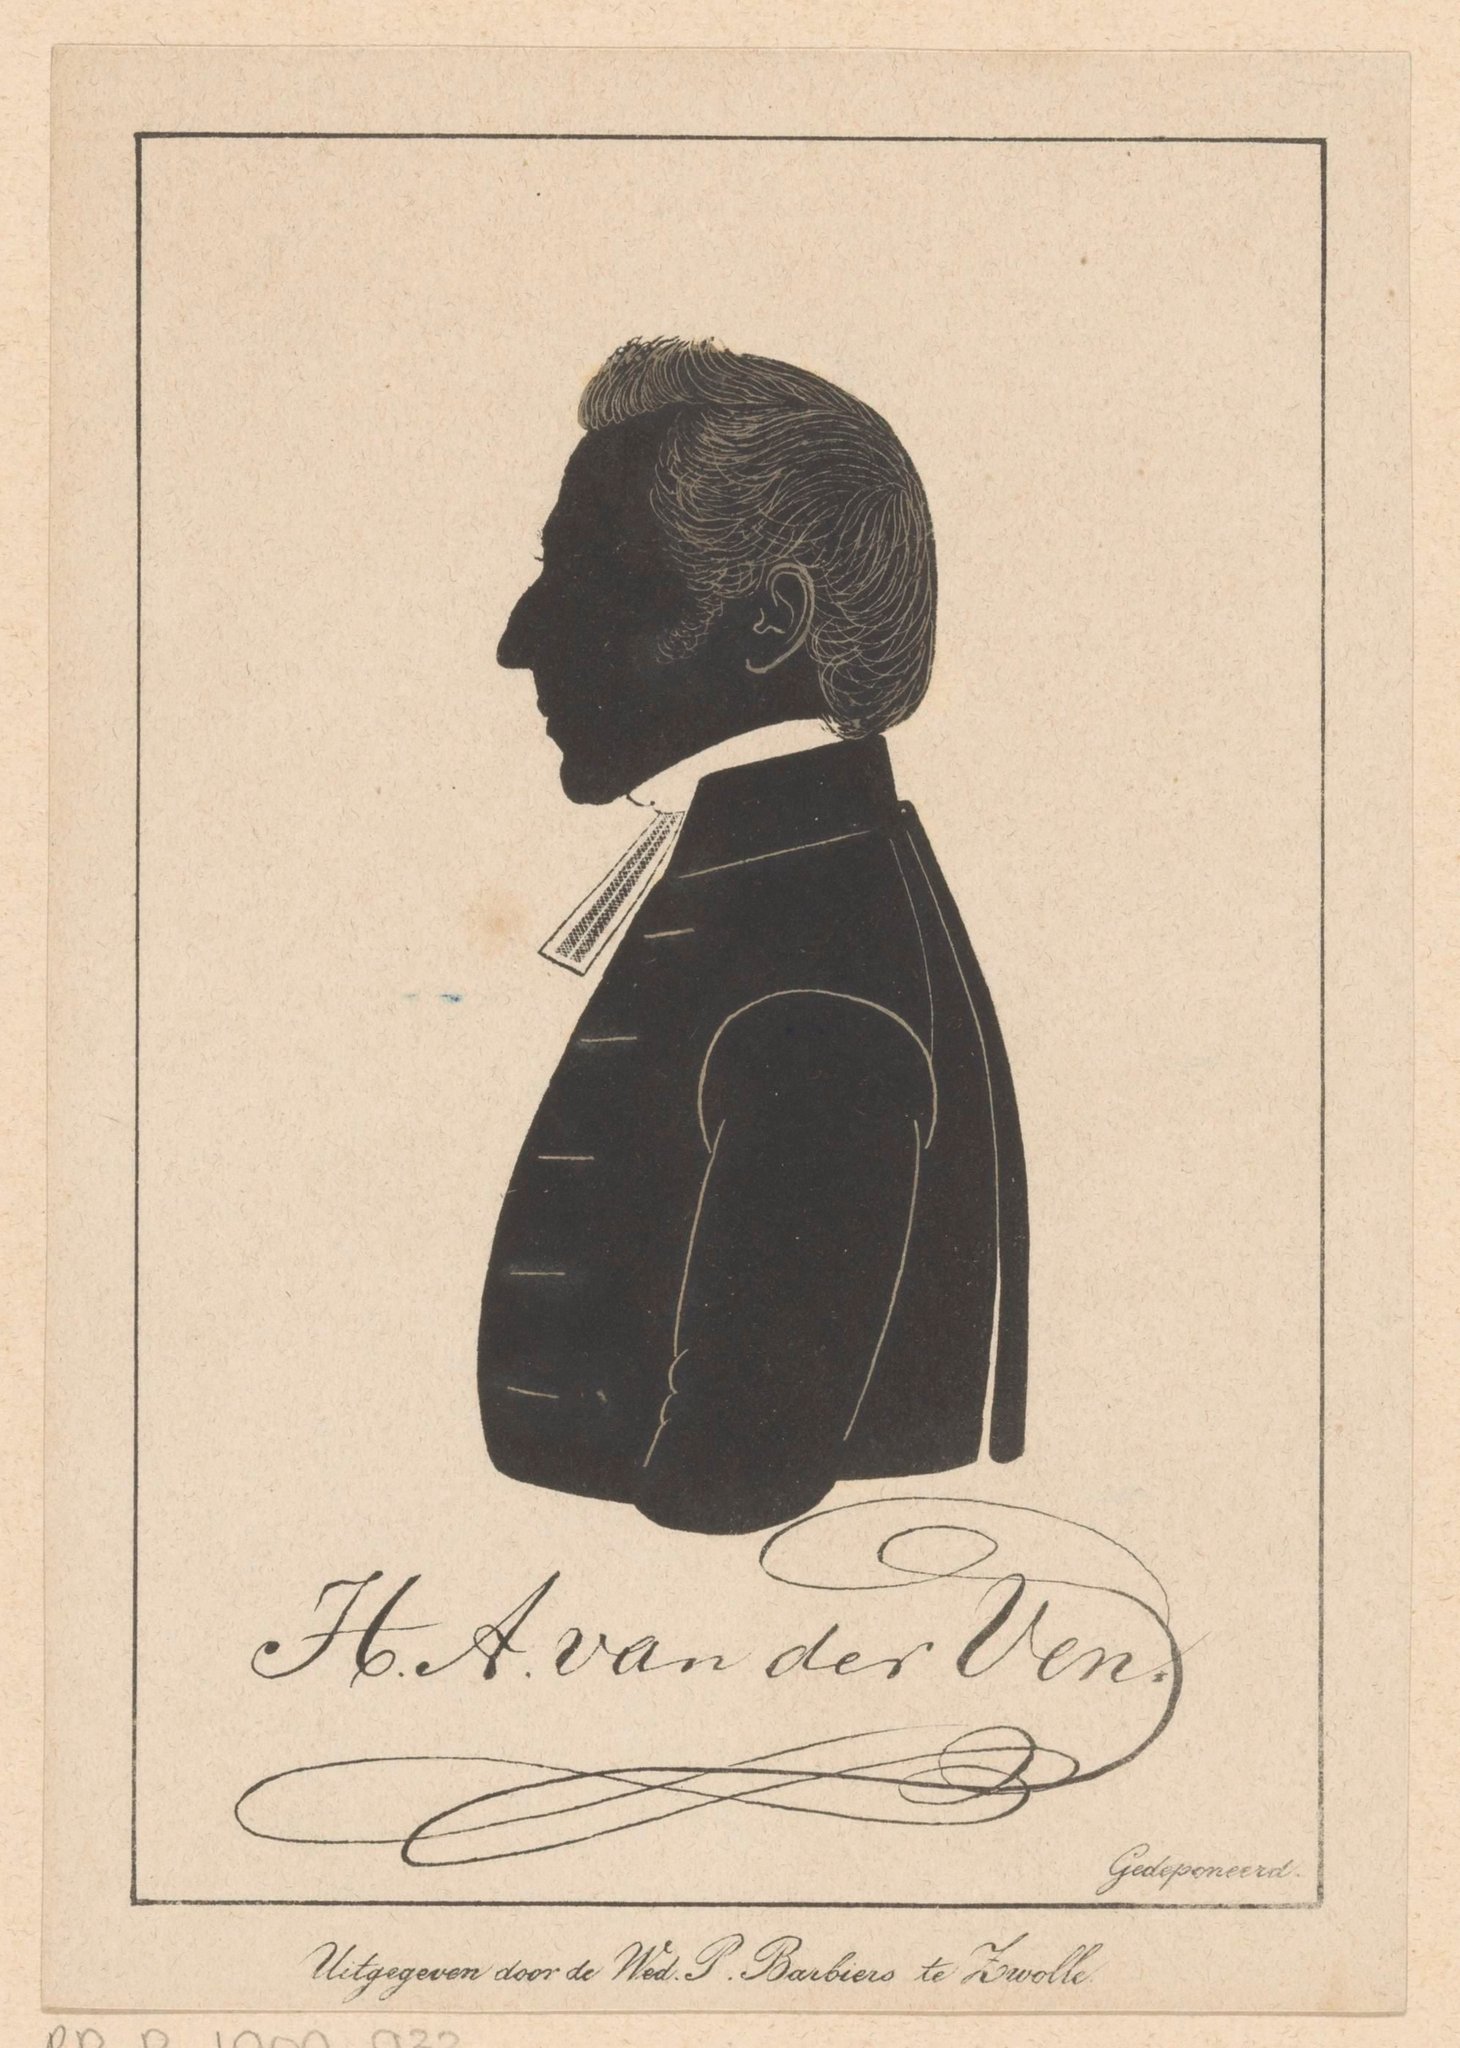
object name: print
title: Silhouetportret van Hermannus Antonius van der Ven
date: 1848-1862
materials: paper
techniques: hand coloring, lithograph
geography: zwolle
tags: historical persons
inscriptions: collector's mark: Lugt 2228, : ‘Gedeponeerd.’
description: Onder het portret de signatuur van de geportretteerde.